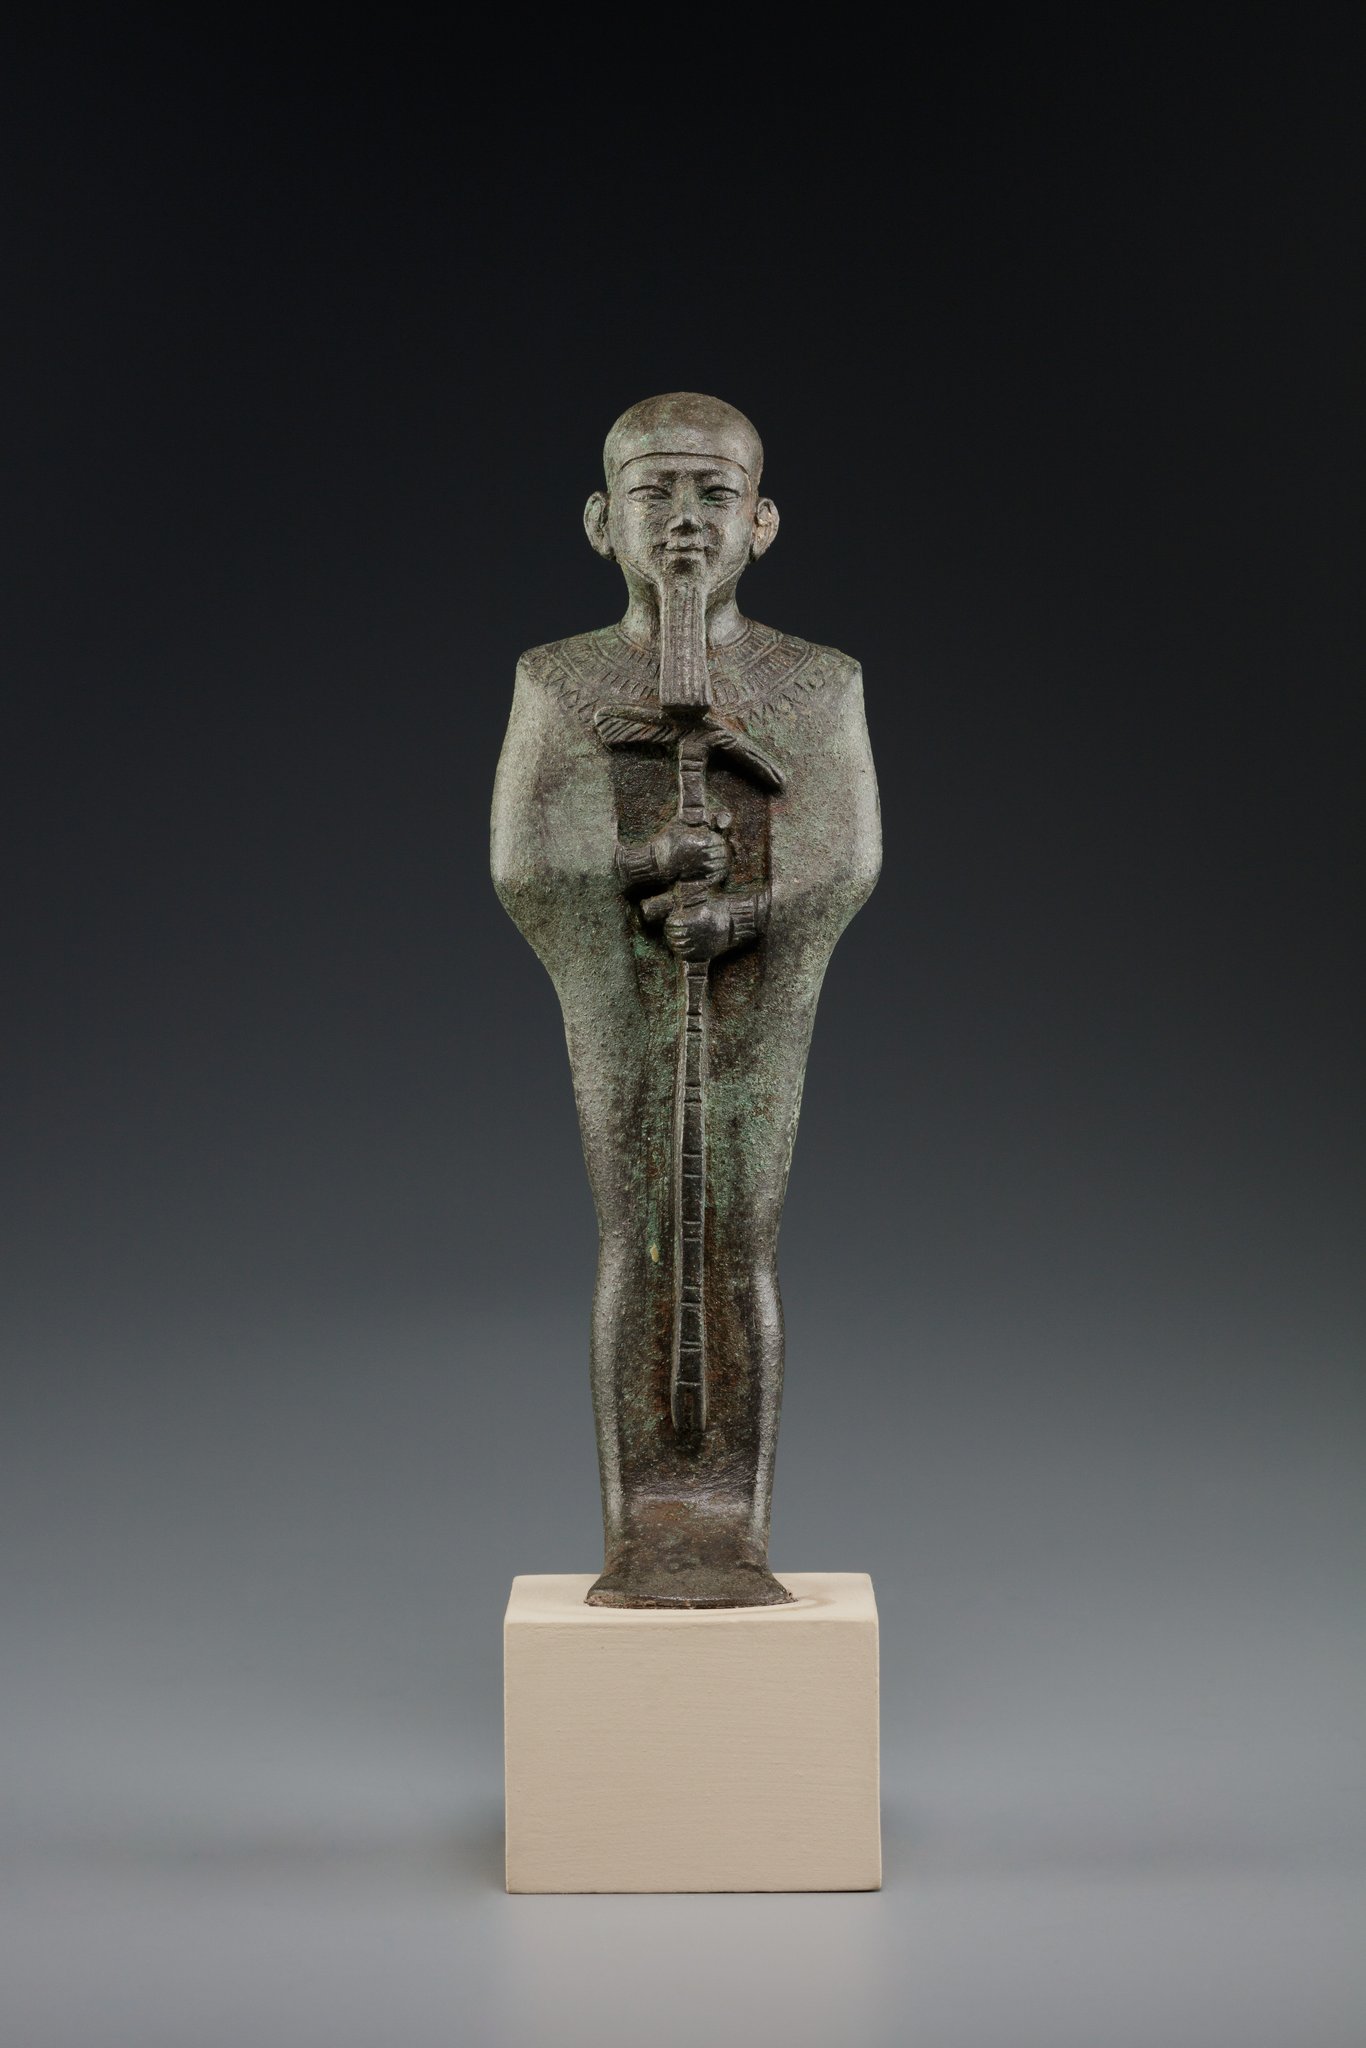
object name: statuette, ptah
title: Ptah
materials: bronze, copper alloy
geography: egypt